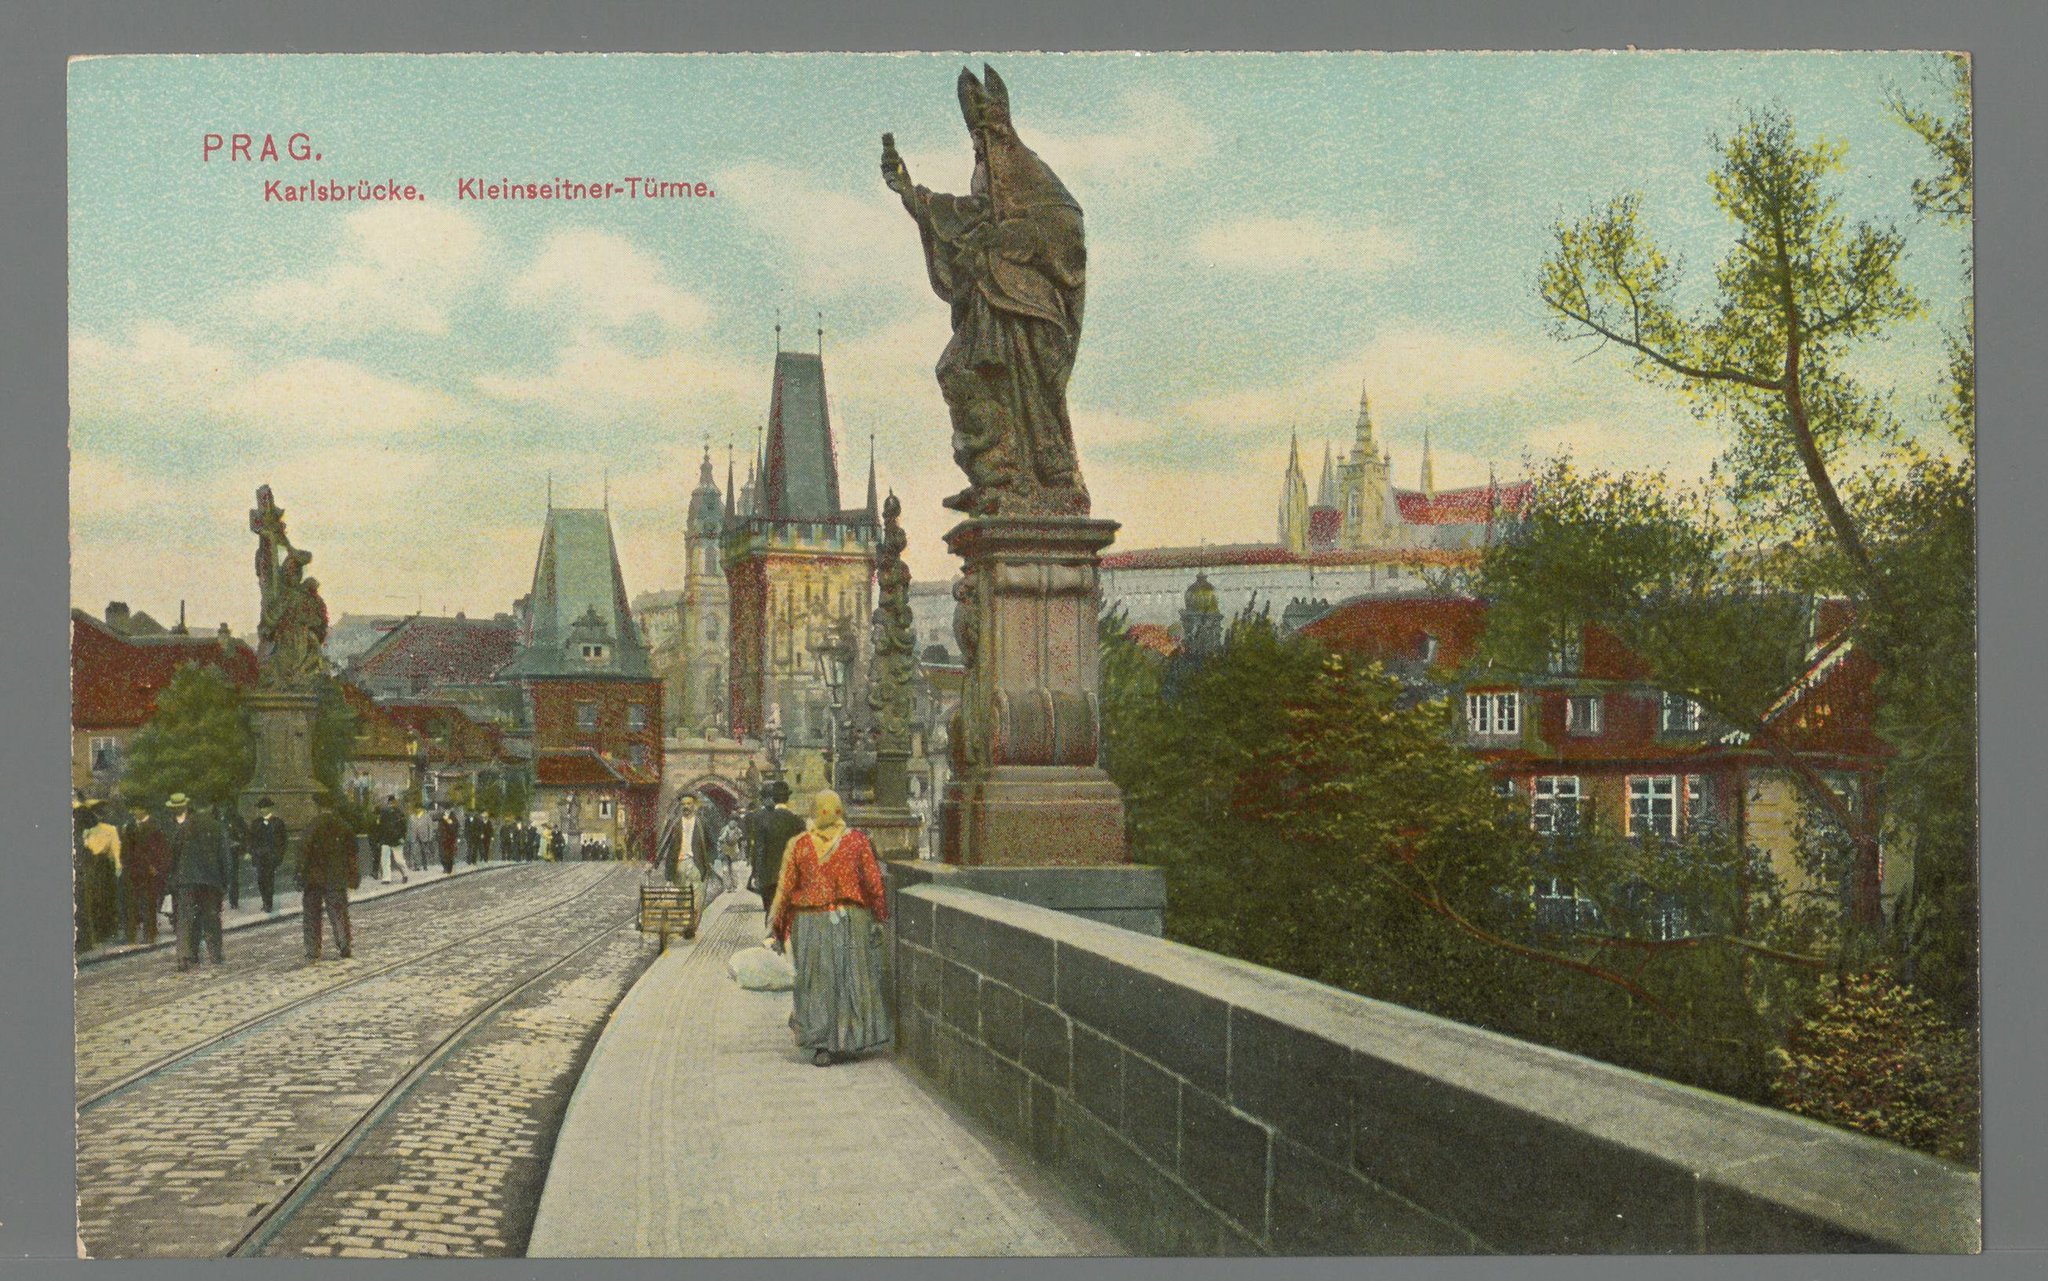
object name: photomechanical print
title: Prag. Karlsbrücke. Kleinseitner-Türme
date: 1908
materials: cardboard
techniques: lithograph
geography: prague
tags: bridge in city across river, canal, etc., city-gate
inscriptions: date